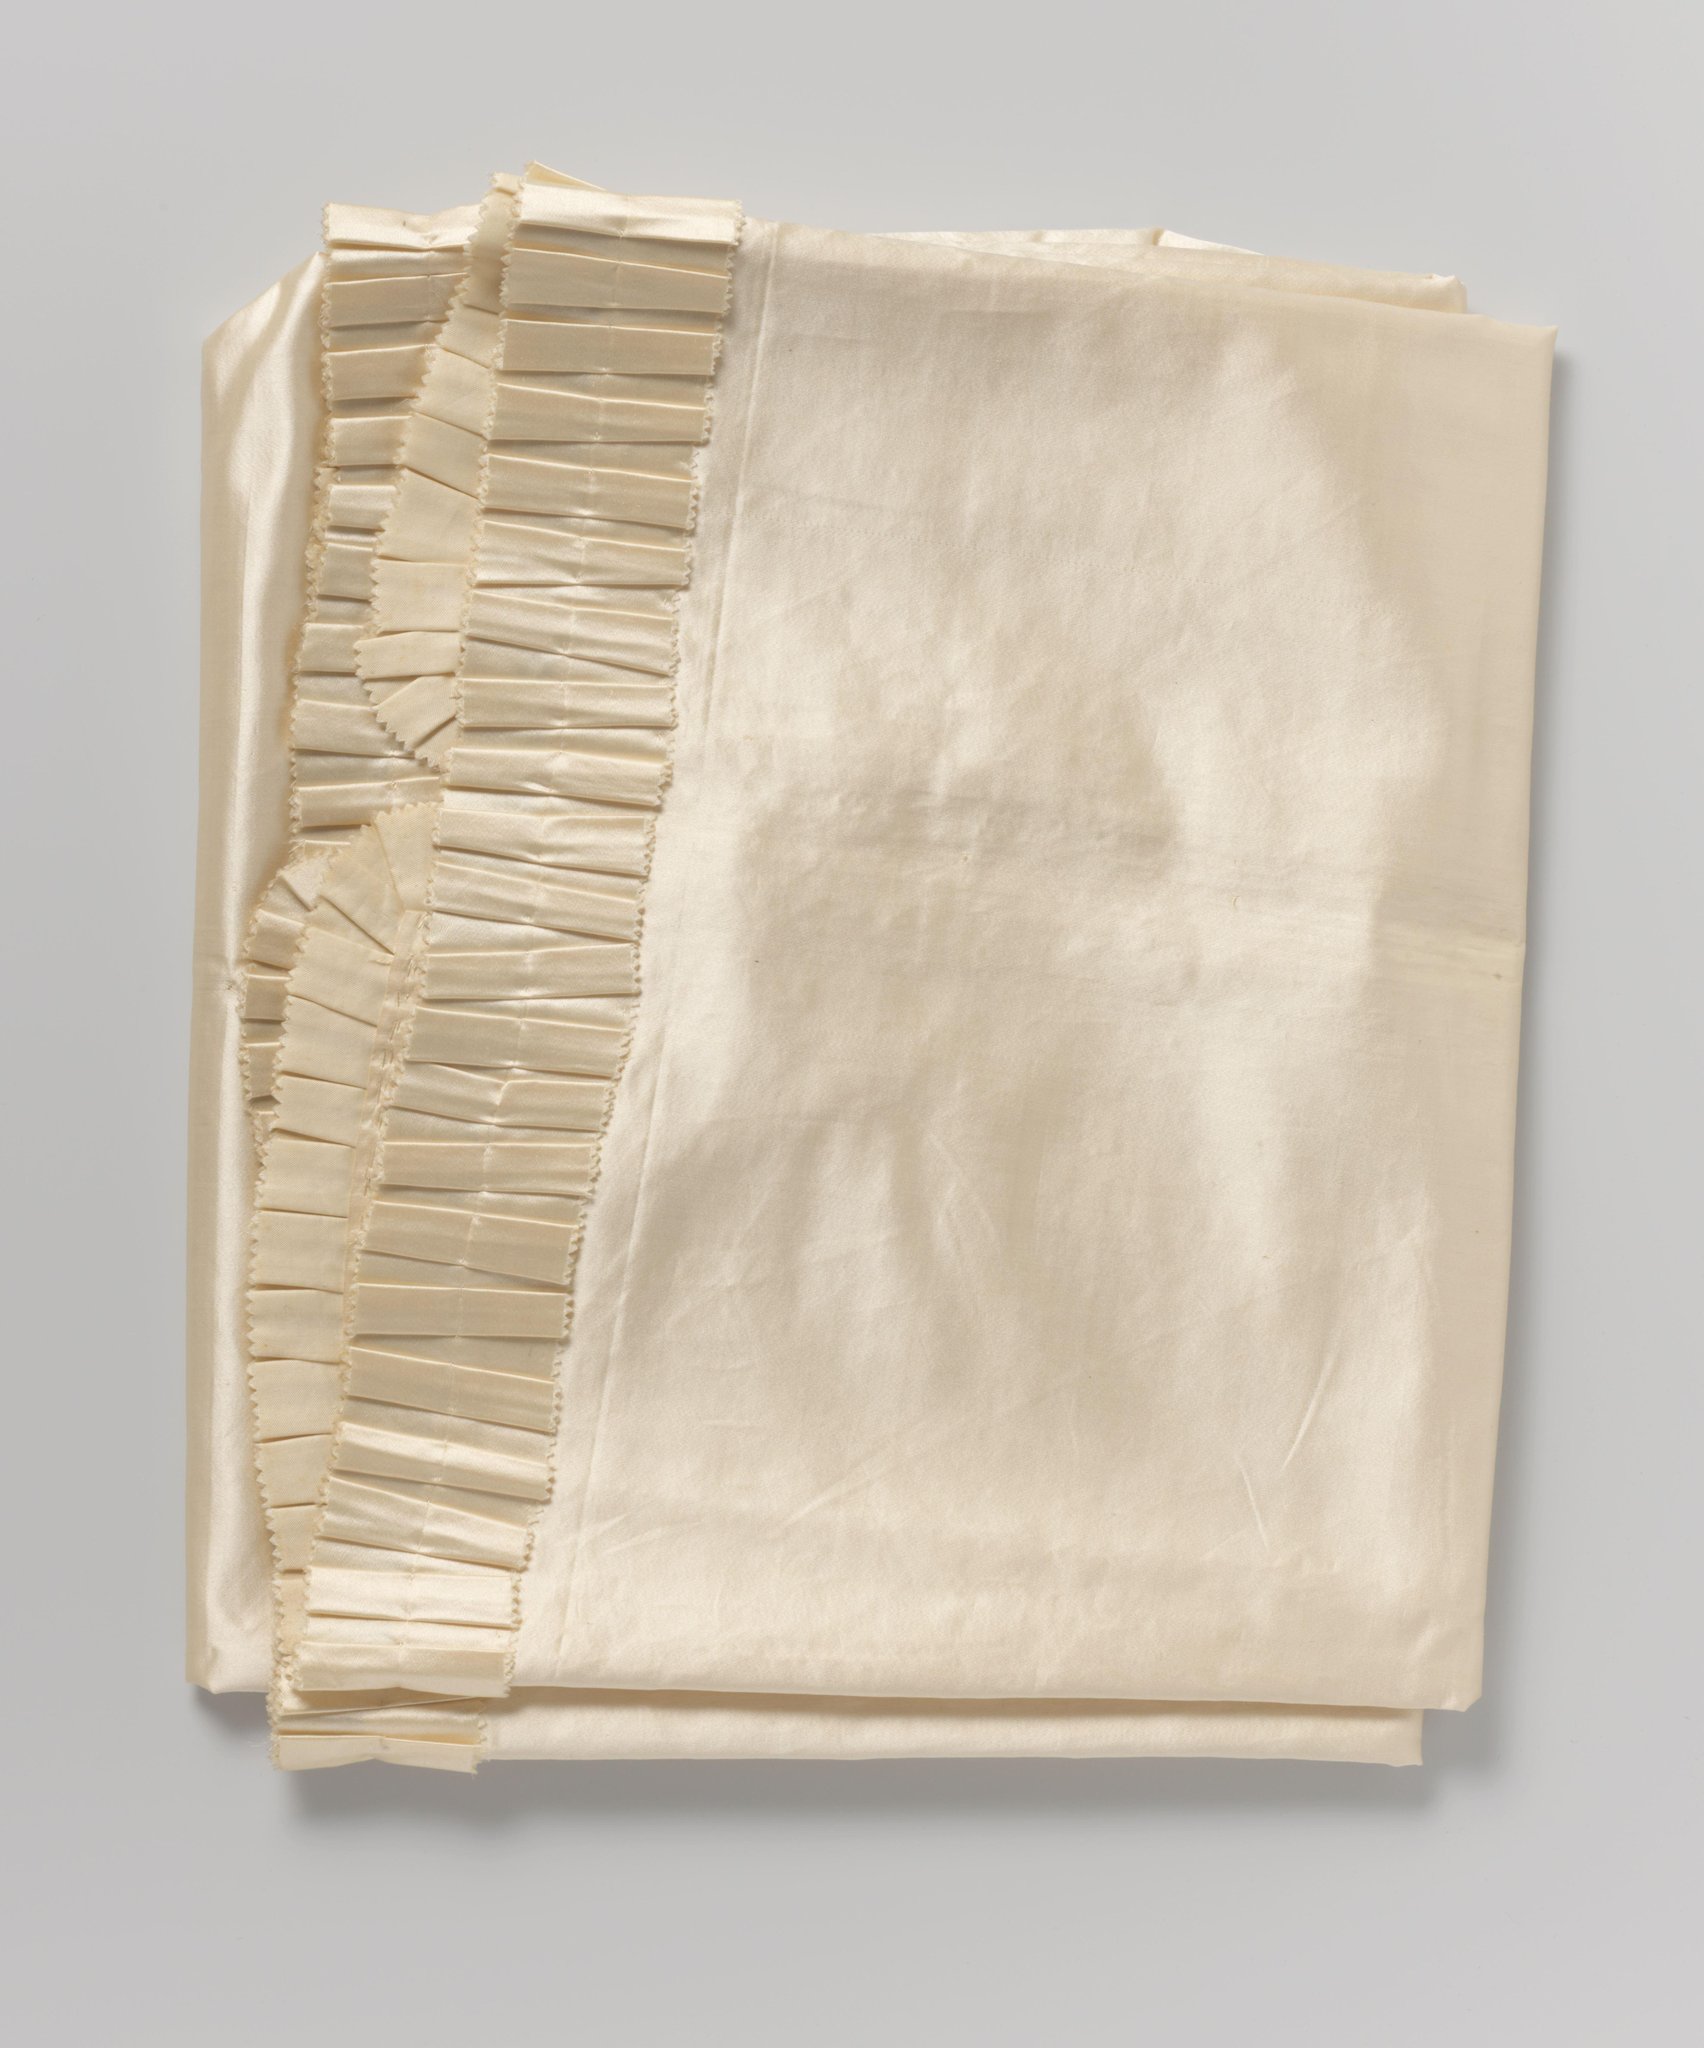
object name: childrenswear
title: Babydekkleed van crêmekleurige satijn met strook van dezelfde stof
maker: Anonymous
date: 1700-1750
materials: silk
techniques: satin binding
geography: netherlands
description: Babydekkleed van cremekleurige satijn, met een strook van hetzelfde.